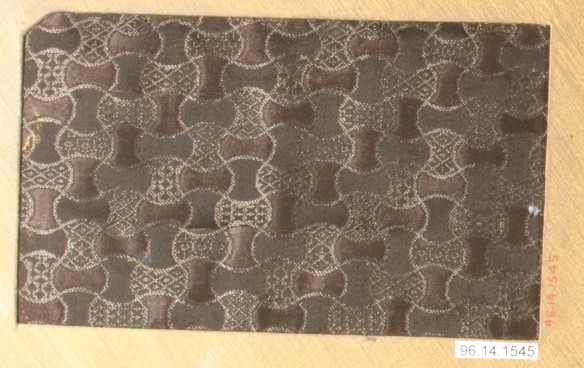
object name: piece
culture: japanese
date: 1701-1900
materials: silk